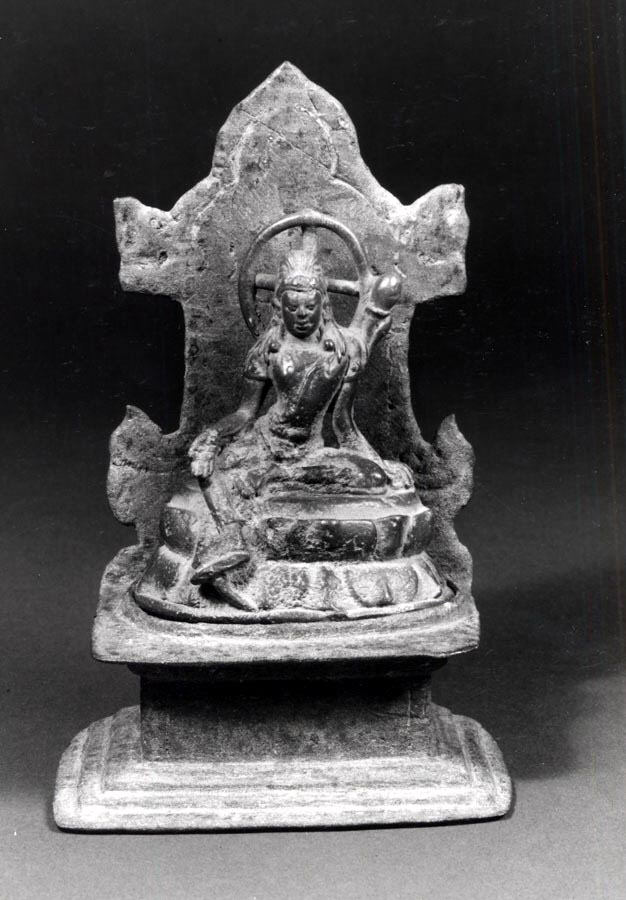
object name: figure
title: Seated Padmapani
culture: indonesian, sumatran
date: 901-1100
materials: bronze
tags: buddhism,bodhisattvas